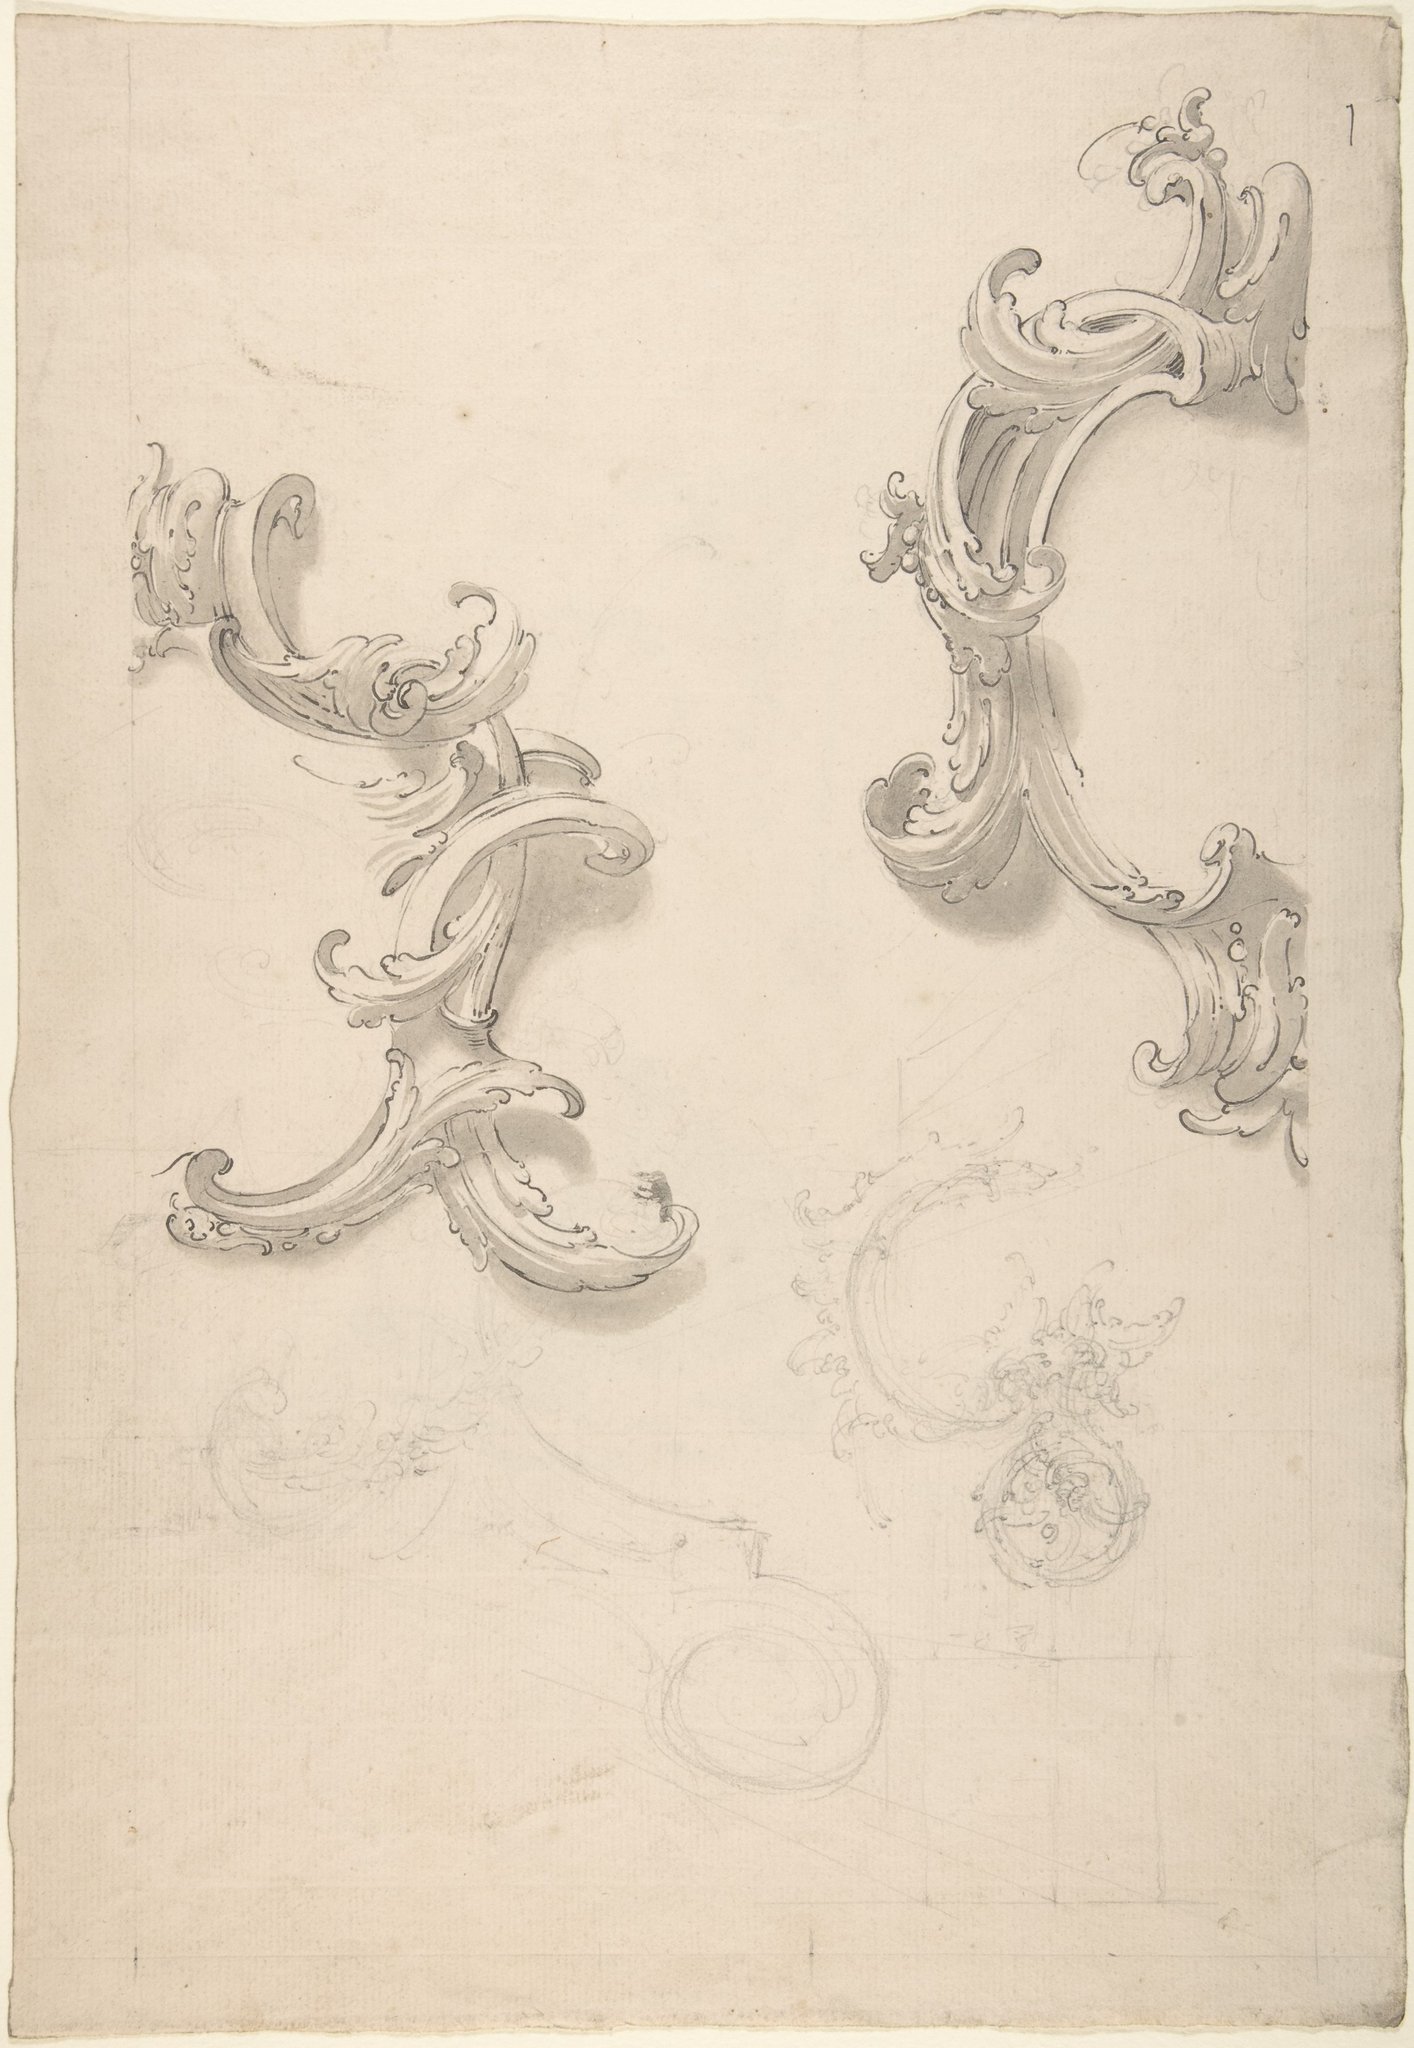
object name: drawing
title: Ornamental Design with Acanthus Leaves (recto); Capital (verso)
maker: anonymous, italian, 18th century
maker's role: artist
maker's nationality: italian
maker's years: 1700-1800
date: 1701-1800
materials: ink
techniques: wash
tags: ornament,acanthus,leaves